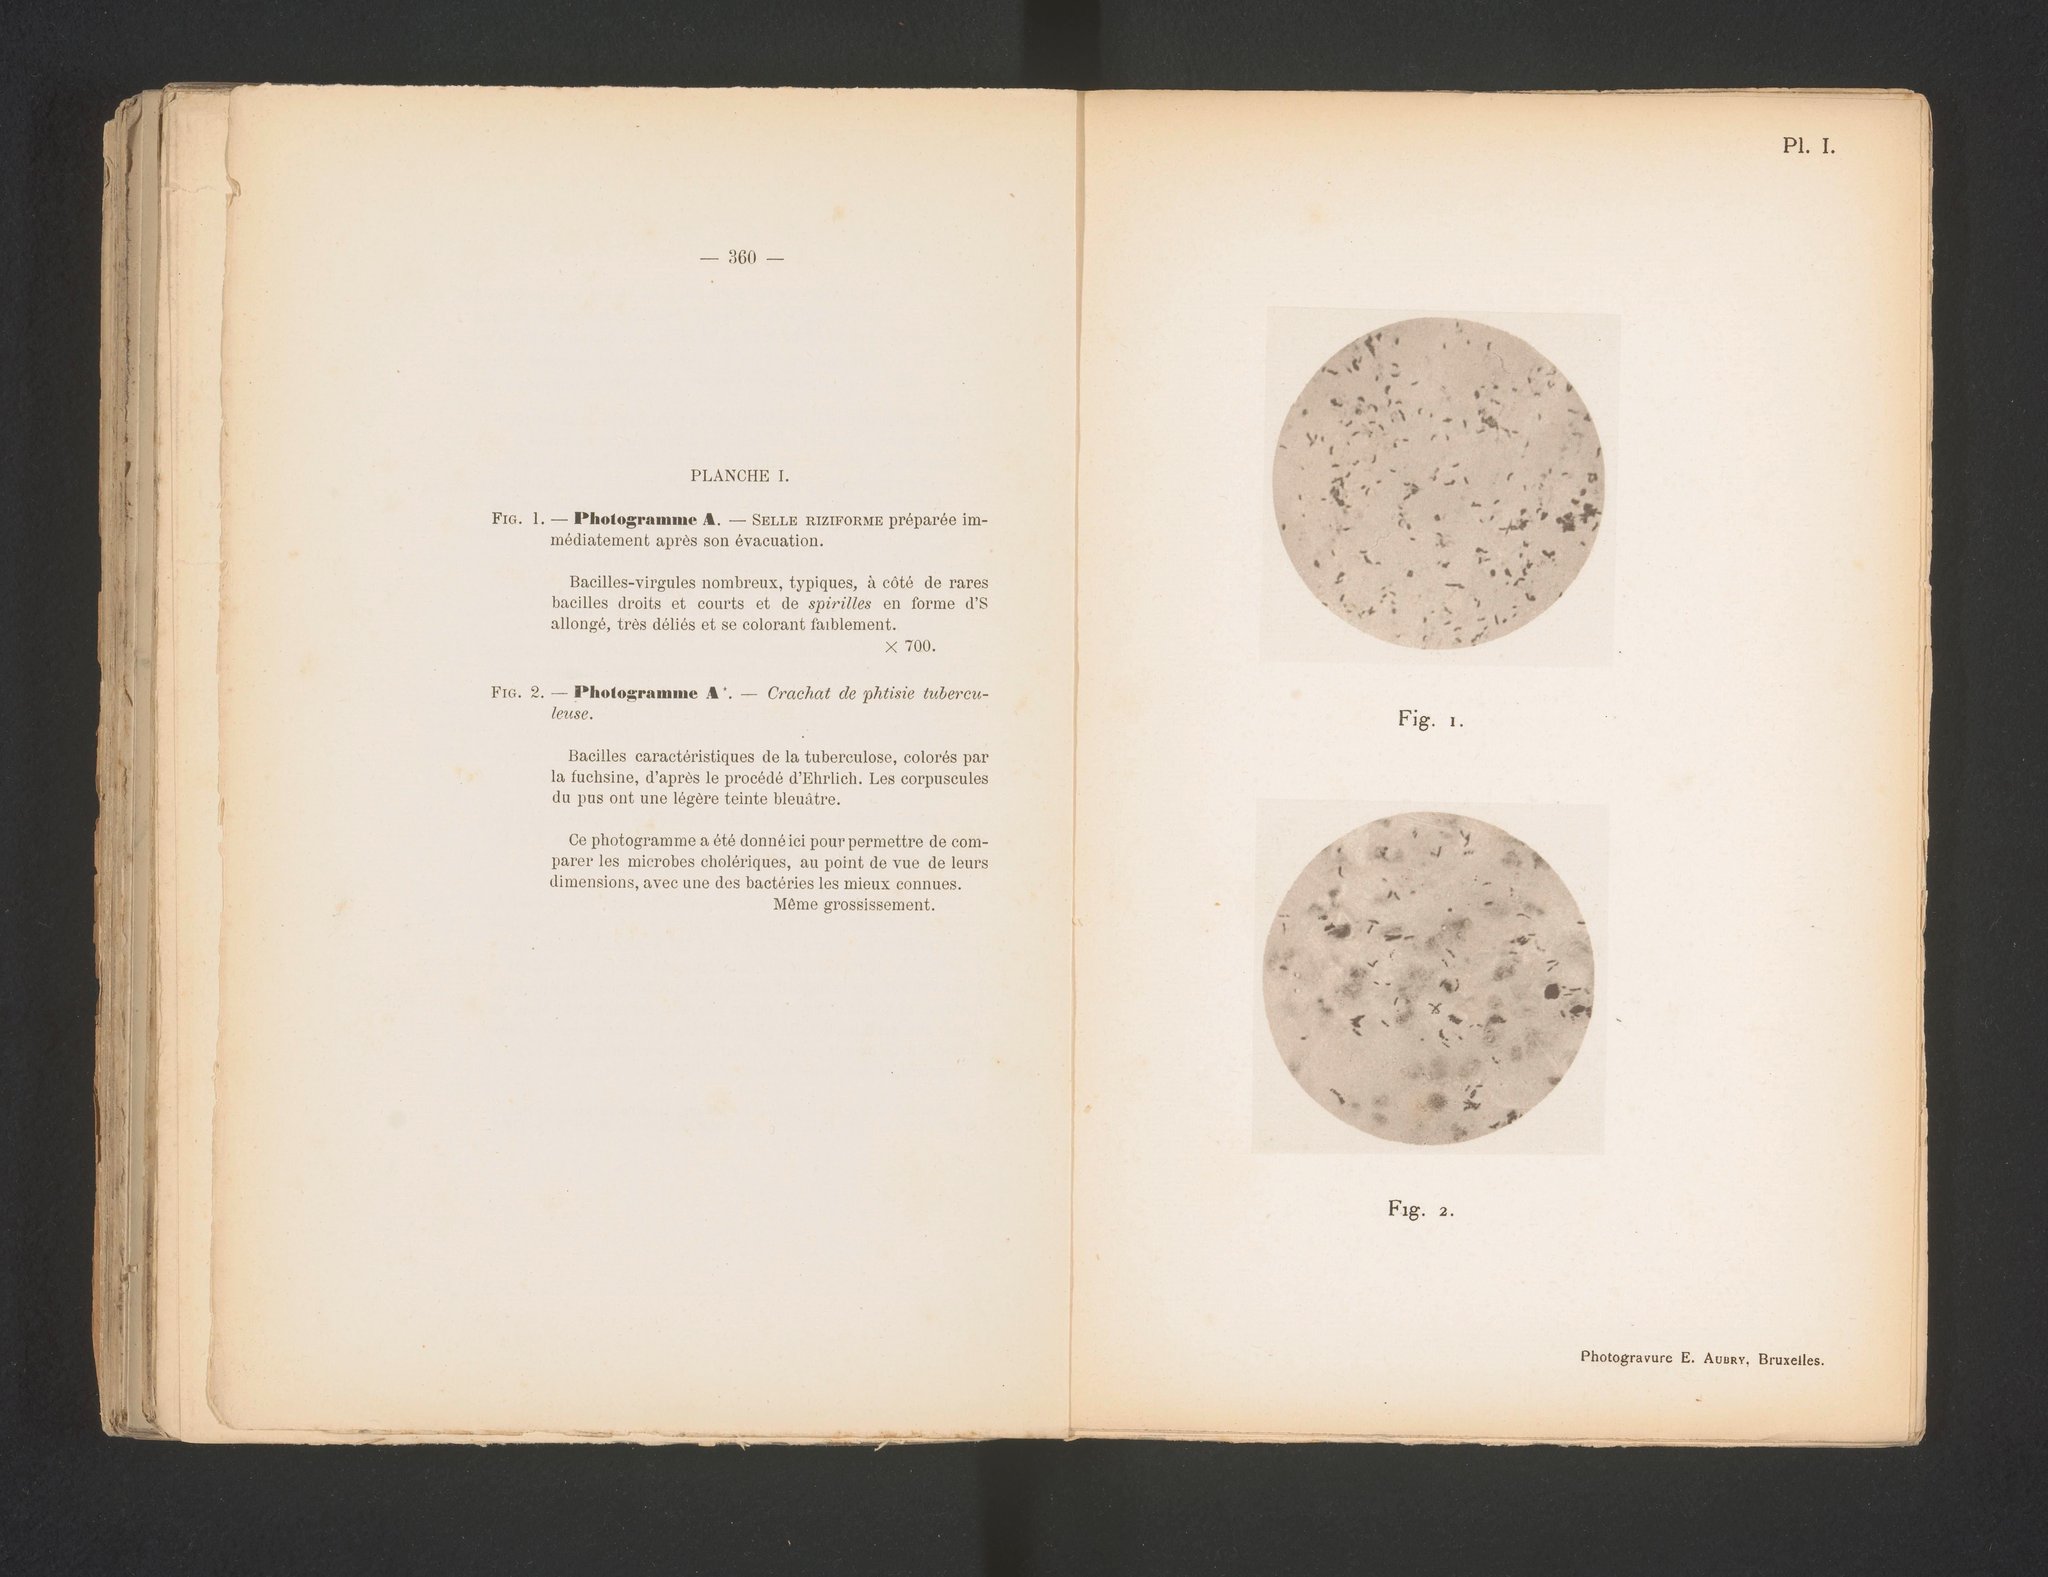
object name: photomechanical print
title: Twee microscoopopname van cholera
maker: émile van ermengem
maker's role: bioloog, fotograaf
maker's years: 1851-1932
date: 1875-1885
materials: paper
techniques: photograph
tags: diseases affecting the whole body, microscope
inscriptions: inscription: ‘Fig. 1.- Photogramme A. Selle rizifrome préparée immédiatement après son évacuation. (...) Fig. 2. - Photogramme A. Crachat de phtisie tuberculeuse. (...)’, number: ‘Pl. I. Fig. 1. Fig. 2.’